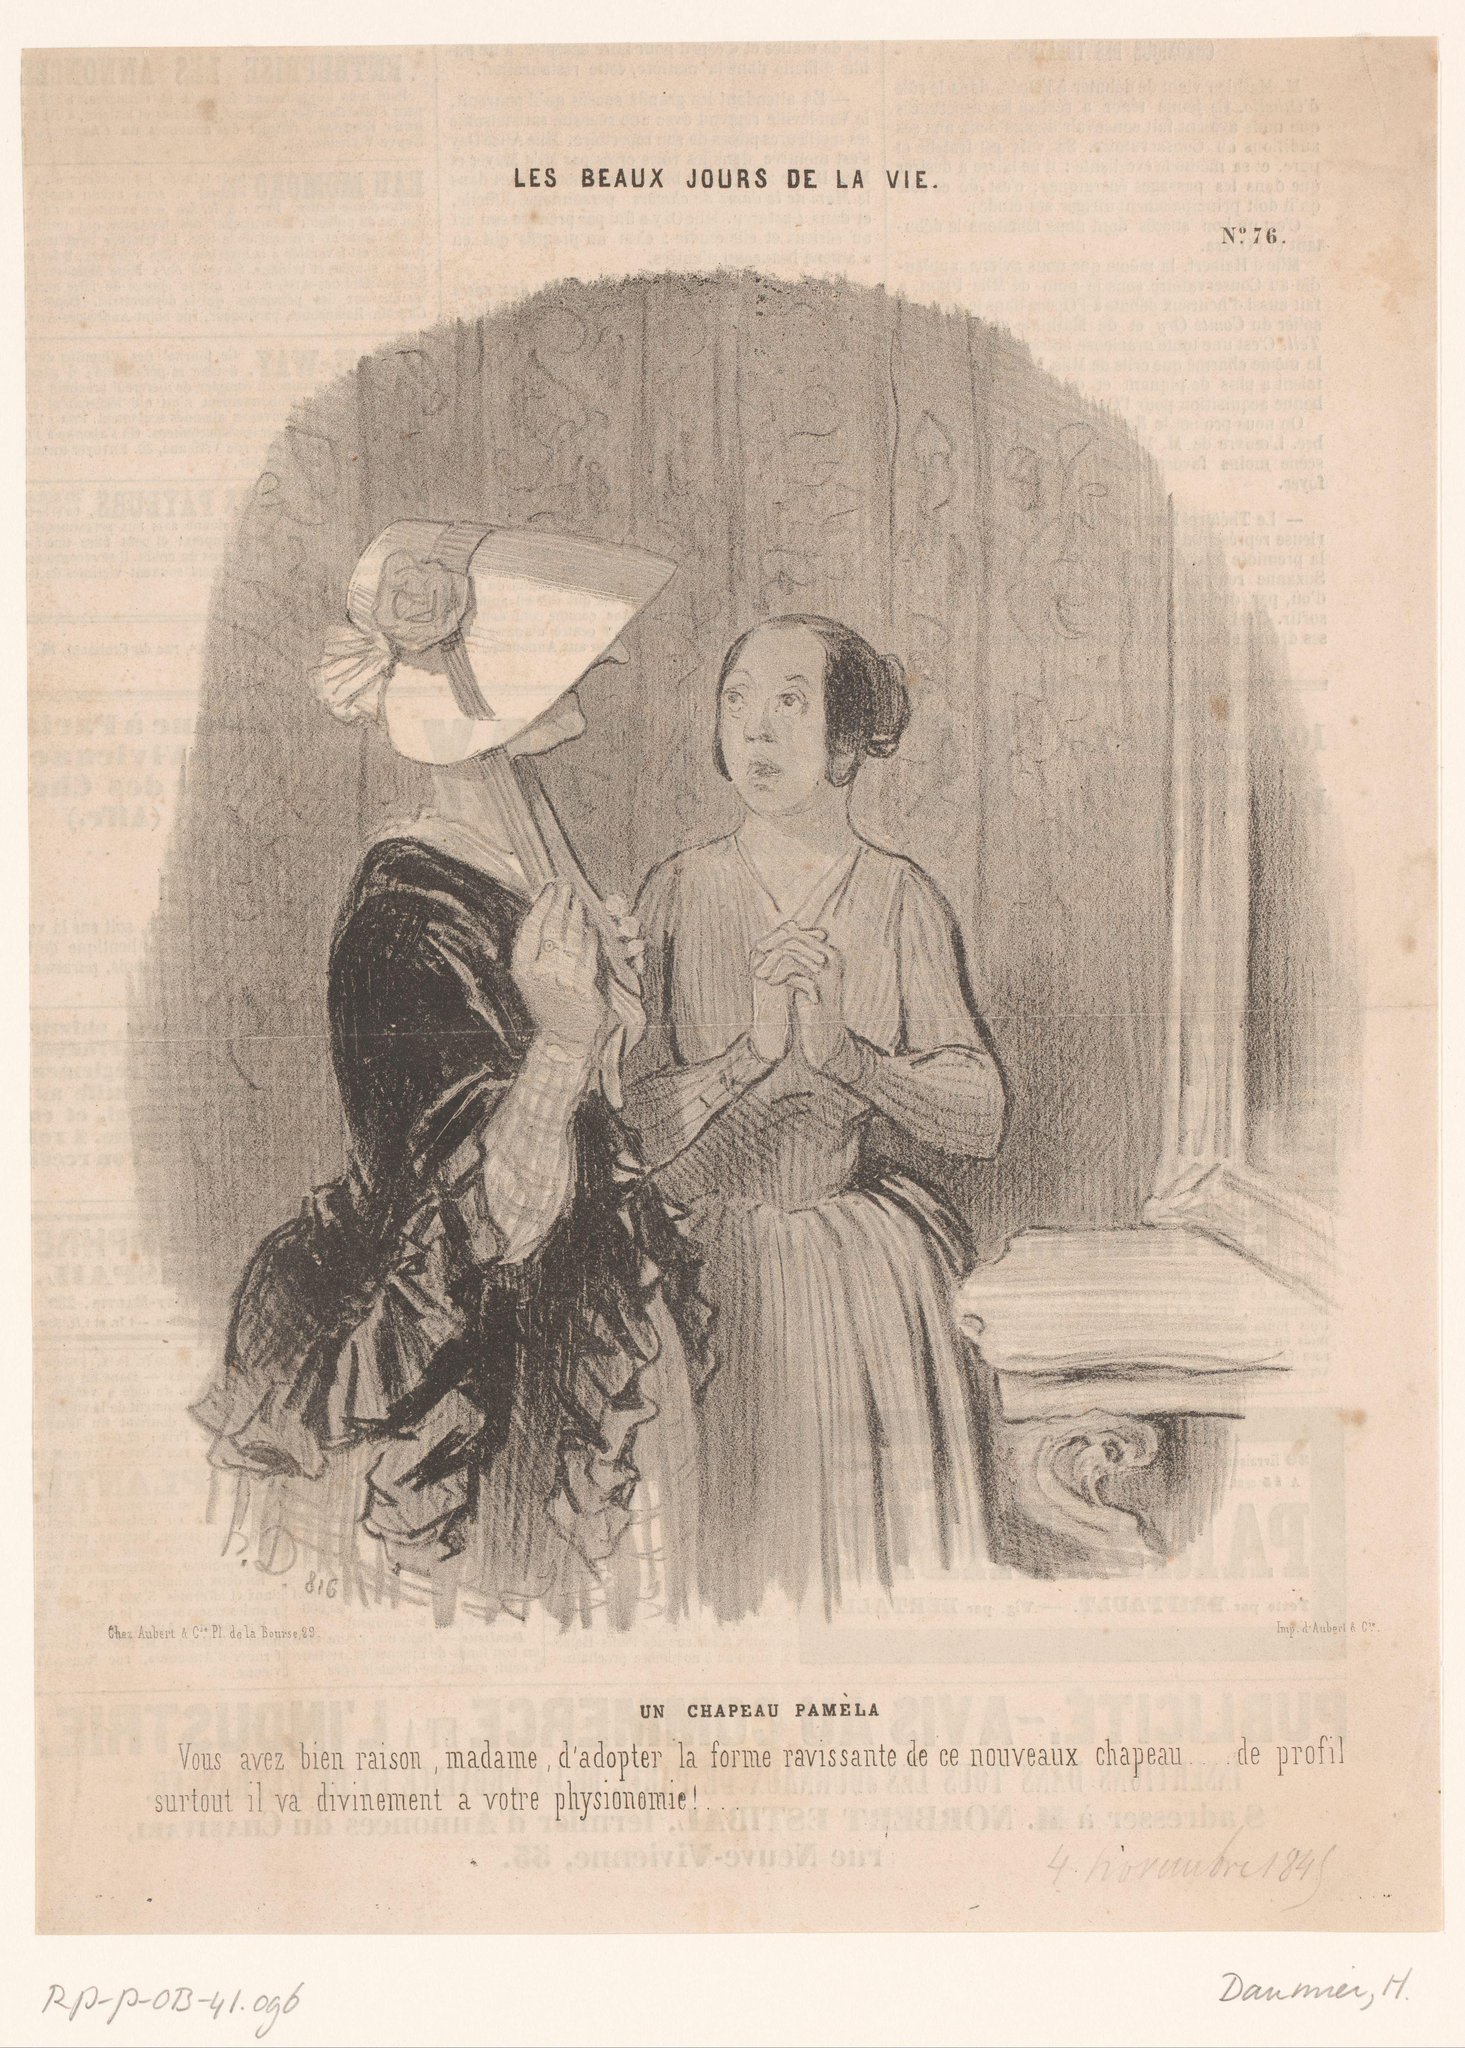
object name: cartoon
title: Les beaux jours de la vie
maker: honoré daumier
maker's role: draughtsman, painter, print maker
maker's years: 1808-1879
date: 1845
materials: paper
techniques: lithograph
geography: paris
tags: caricatures (human types), head-gear: hat, reflection (in a mirror) - aa - (for) women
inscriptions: collector's mark: Lugt 2228a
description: Prent gebruikt voor: Le Charivari, 04-11-1845.